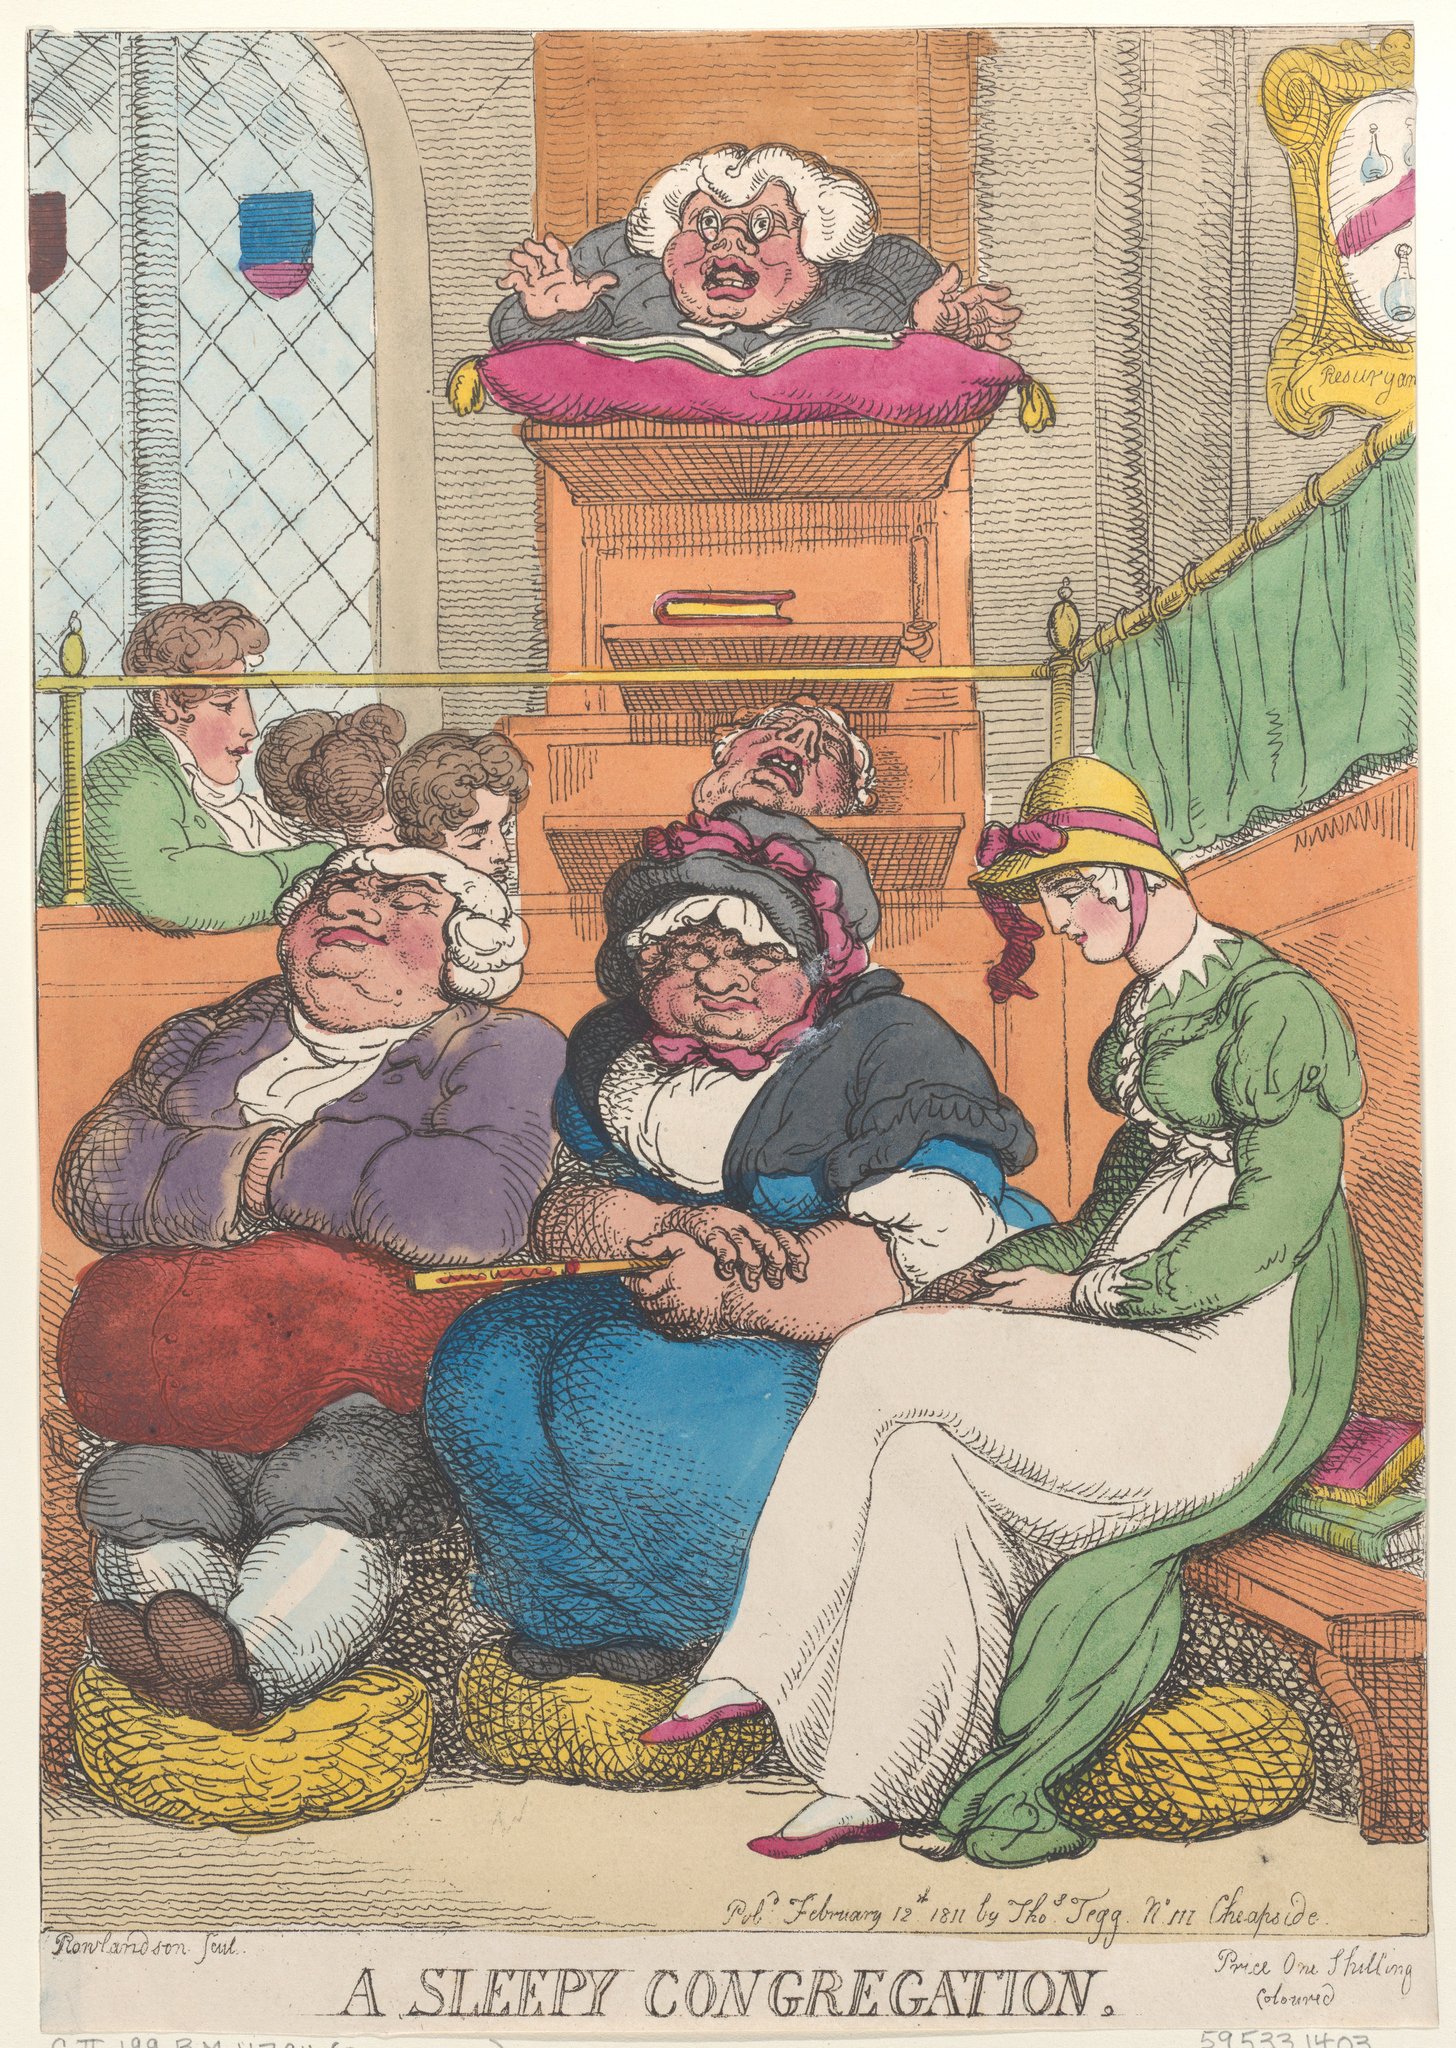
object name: print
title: A Sleepy Congregation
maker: thomas rowlandson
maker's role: artist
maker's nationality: british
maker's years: 1757-1827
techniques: etching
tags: satire,churches,sleeping,men,women